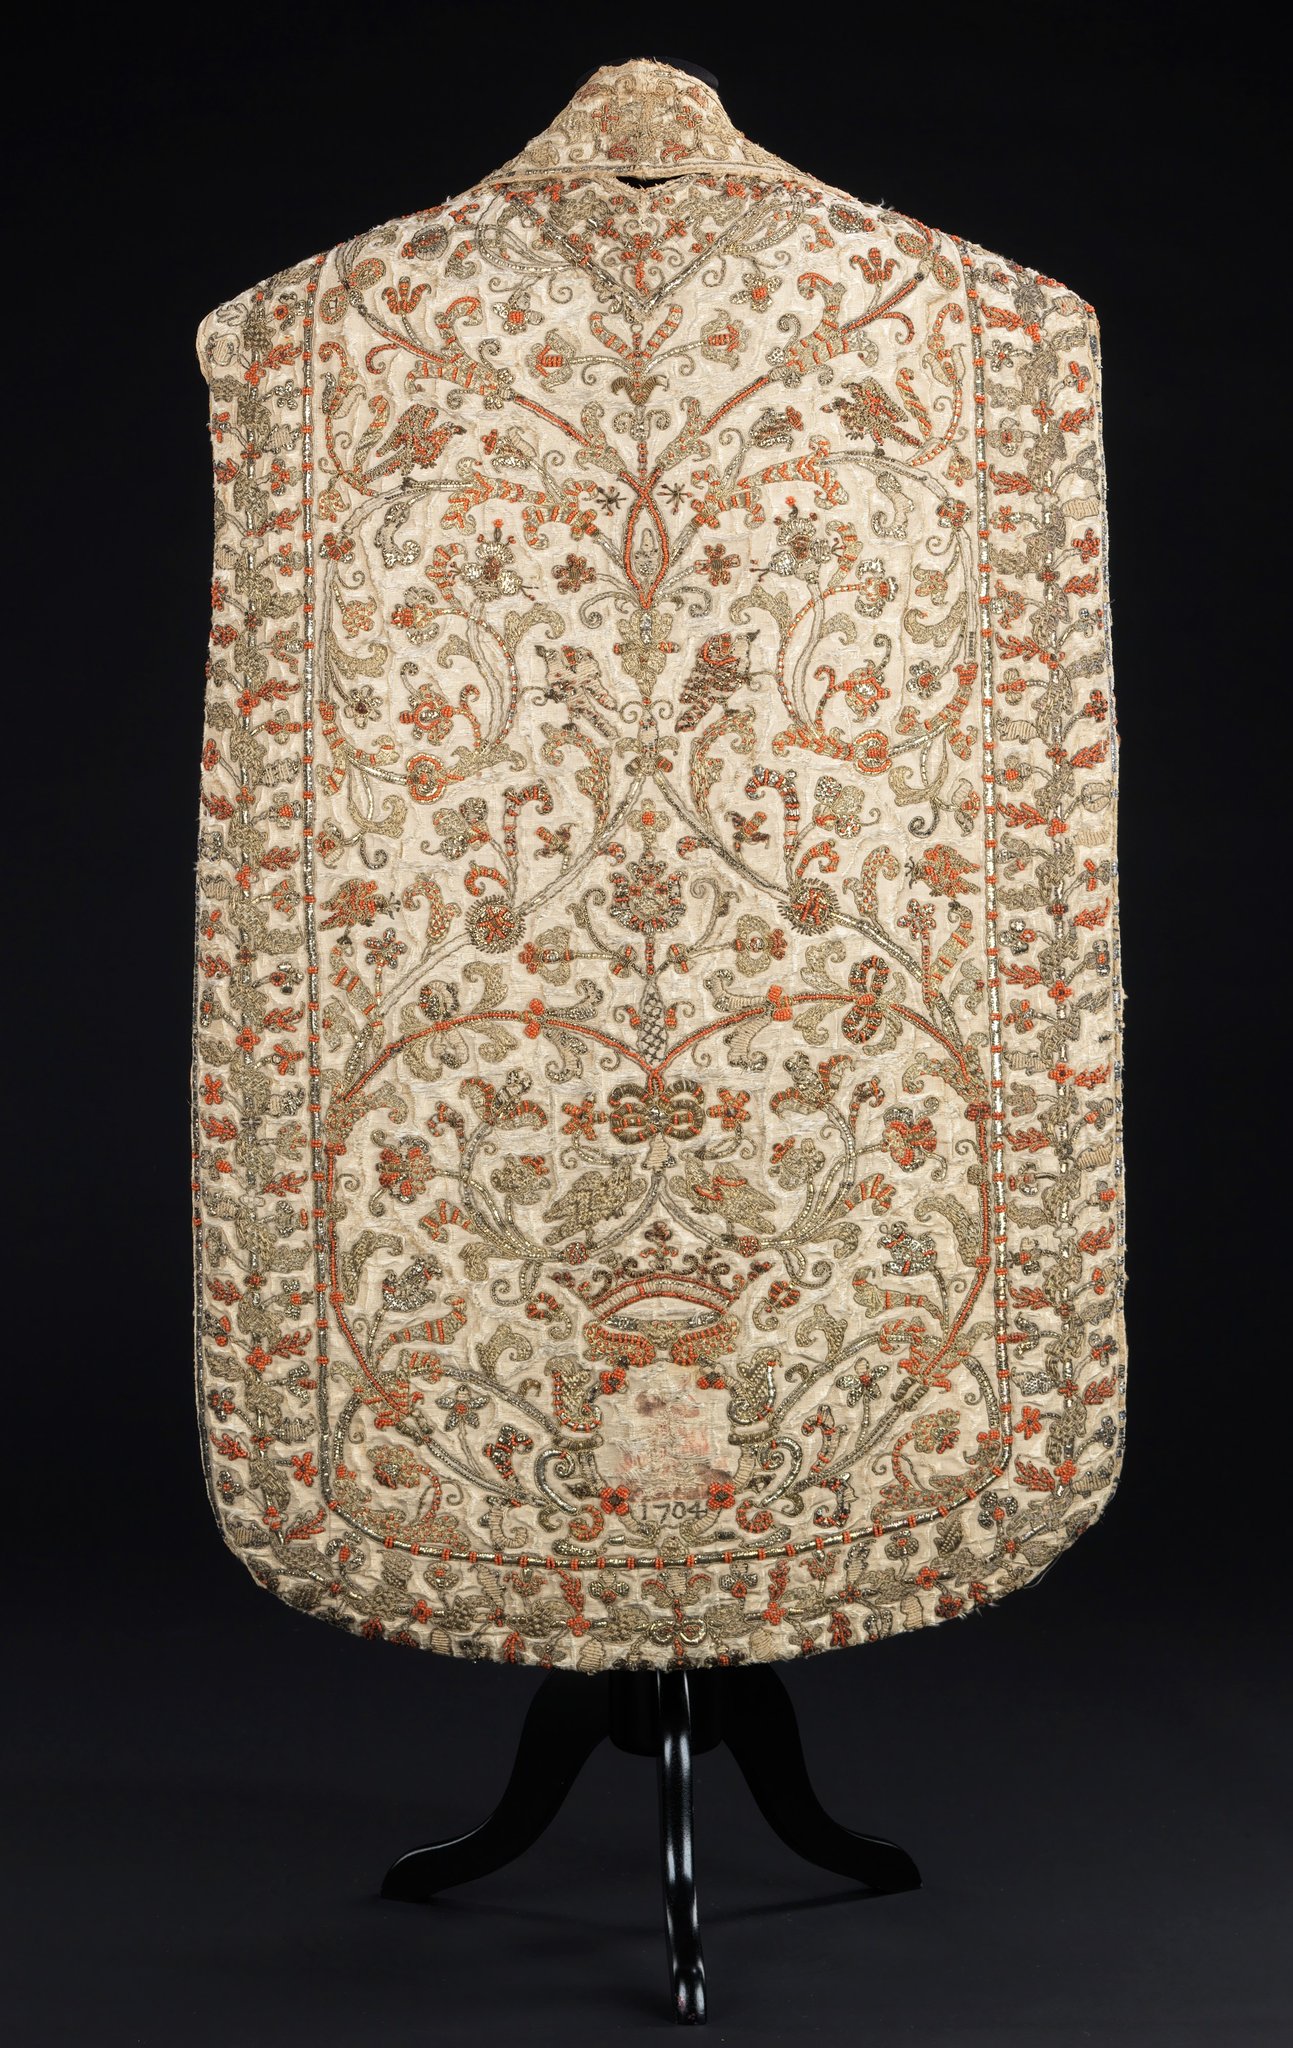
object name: vestment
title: Chasuble, stole and maniple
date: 1704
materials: coral, linen, metal, silk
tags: birds,flowers